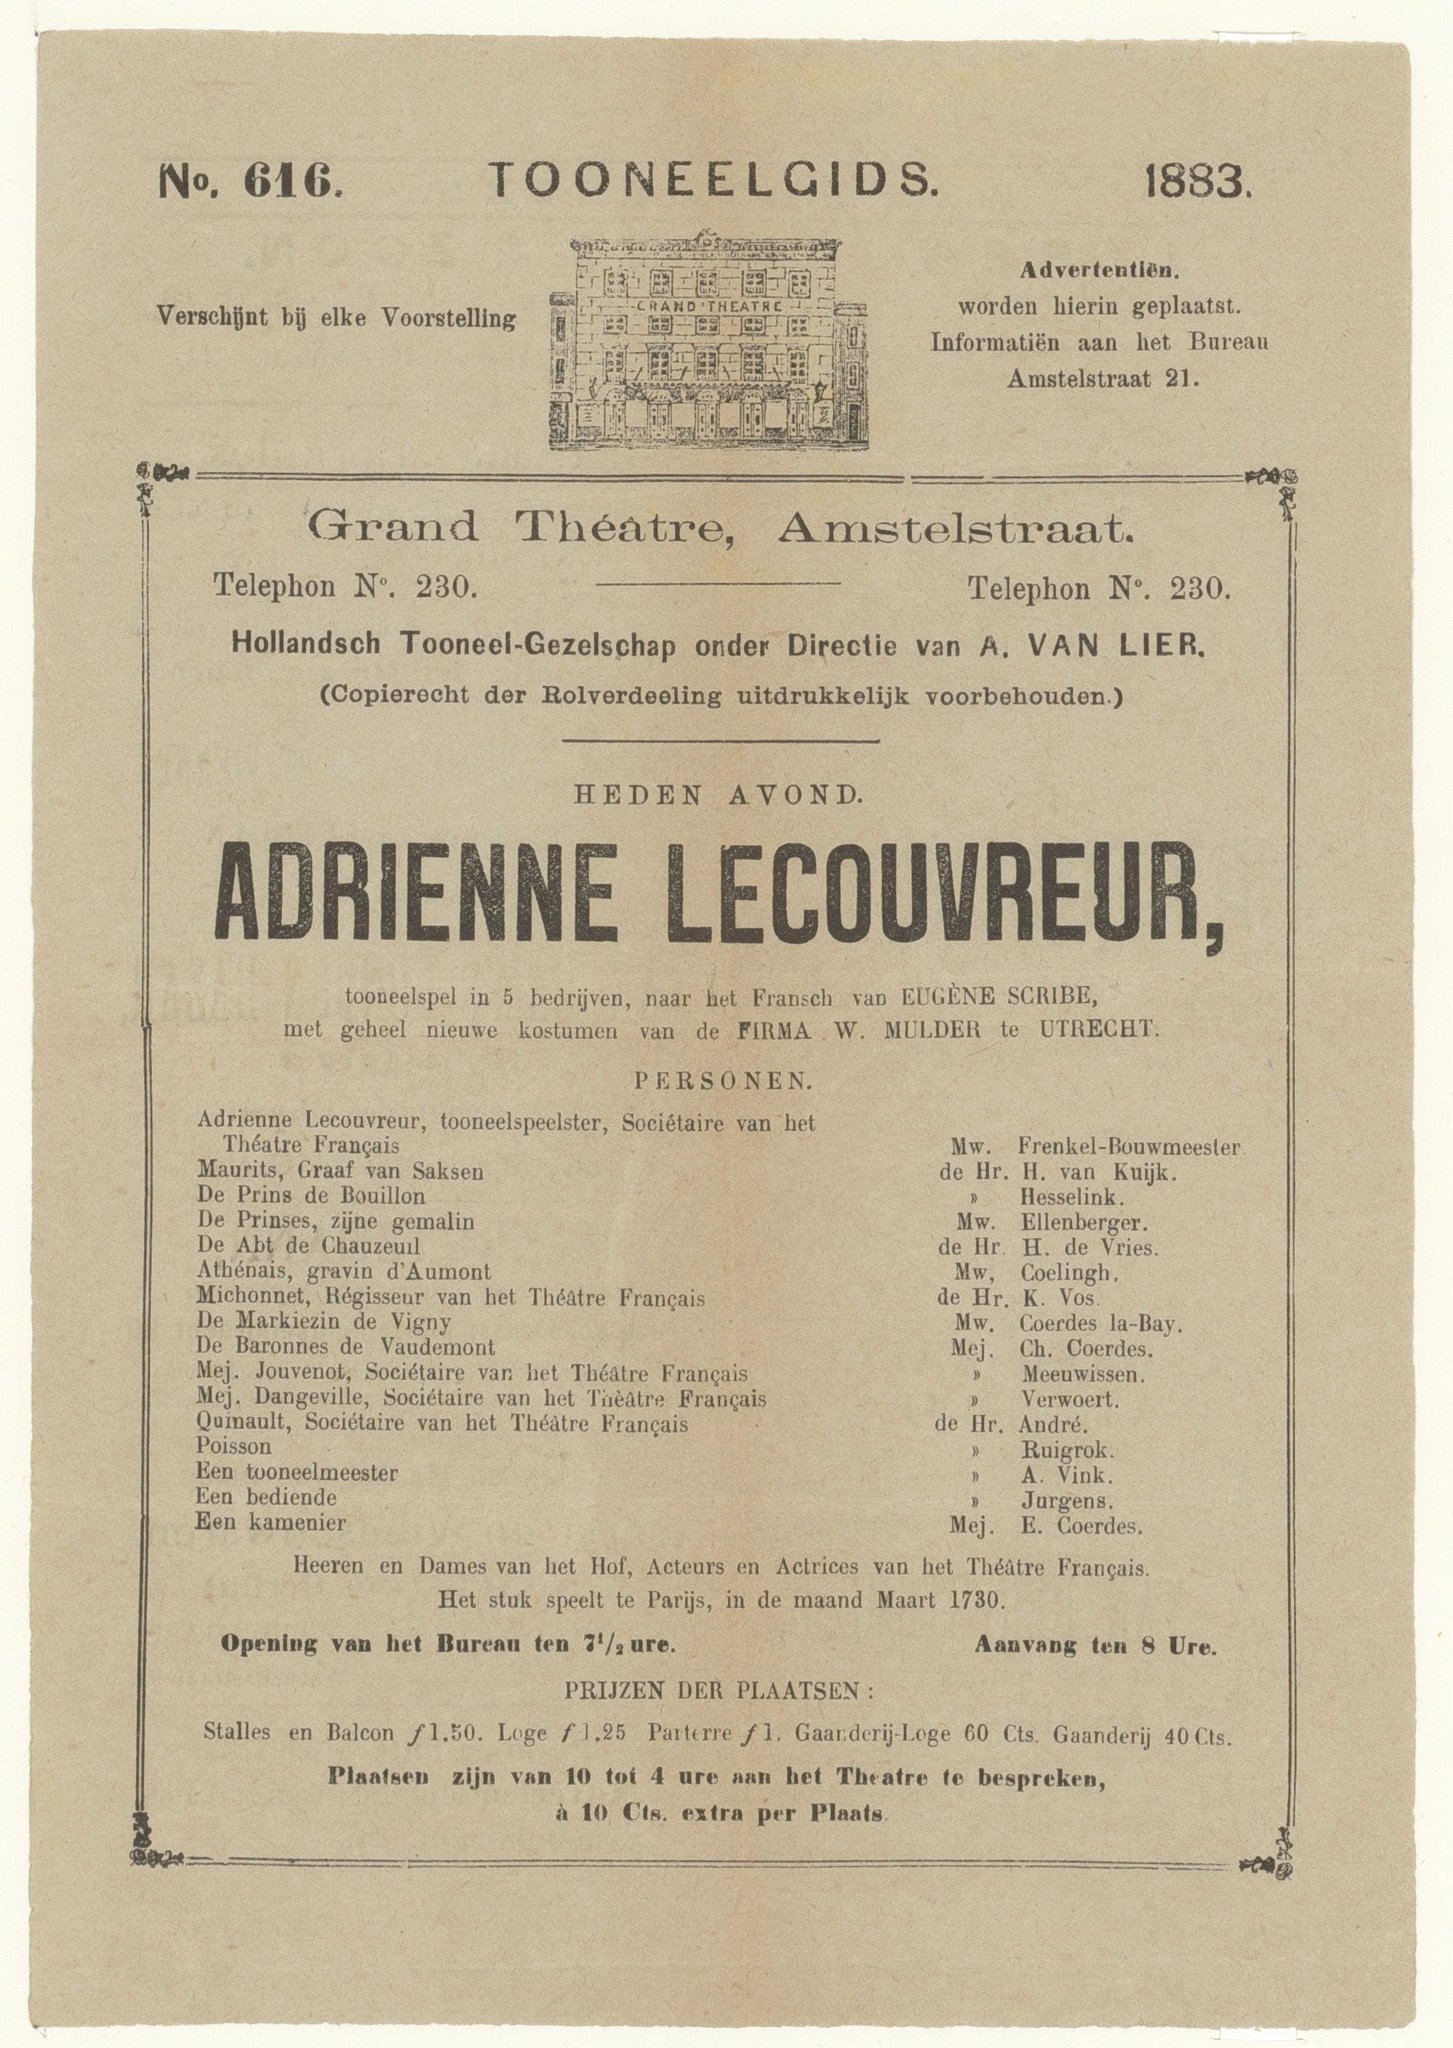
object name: print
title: Tooneelgids met aankondiging van de voorstelling Adrienne Lecouvreur, 1883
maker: Anonymous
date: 1883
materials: paper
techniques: letterpress printing, engraving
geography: amsterdam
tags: theatre, theatrical performance, advertisement, notice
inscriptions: stamp, collector's mark: Lugt 1641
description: Aankondiging van de aankomende voorstelling Adrienne Lecouvreur in de Stadsschouwburg in 1883. Op de overige pagina's advertenties. Linksboven genummerd: No. 616. Onderwerpsrubrieken binnen de Atlas Zeden en Gewoonten: Tooneel, Toneelprogramma’s.